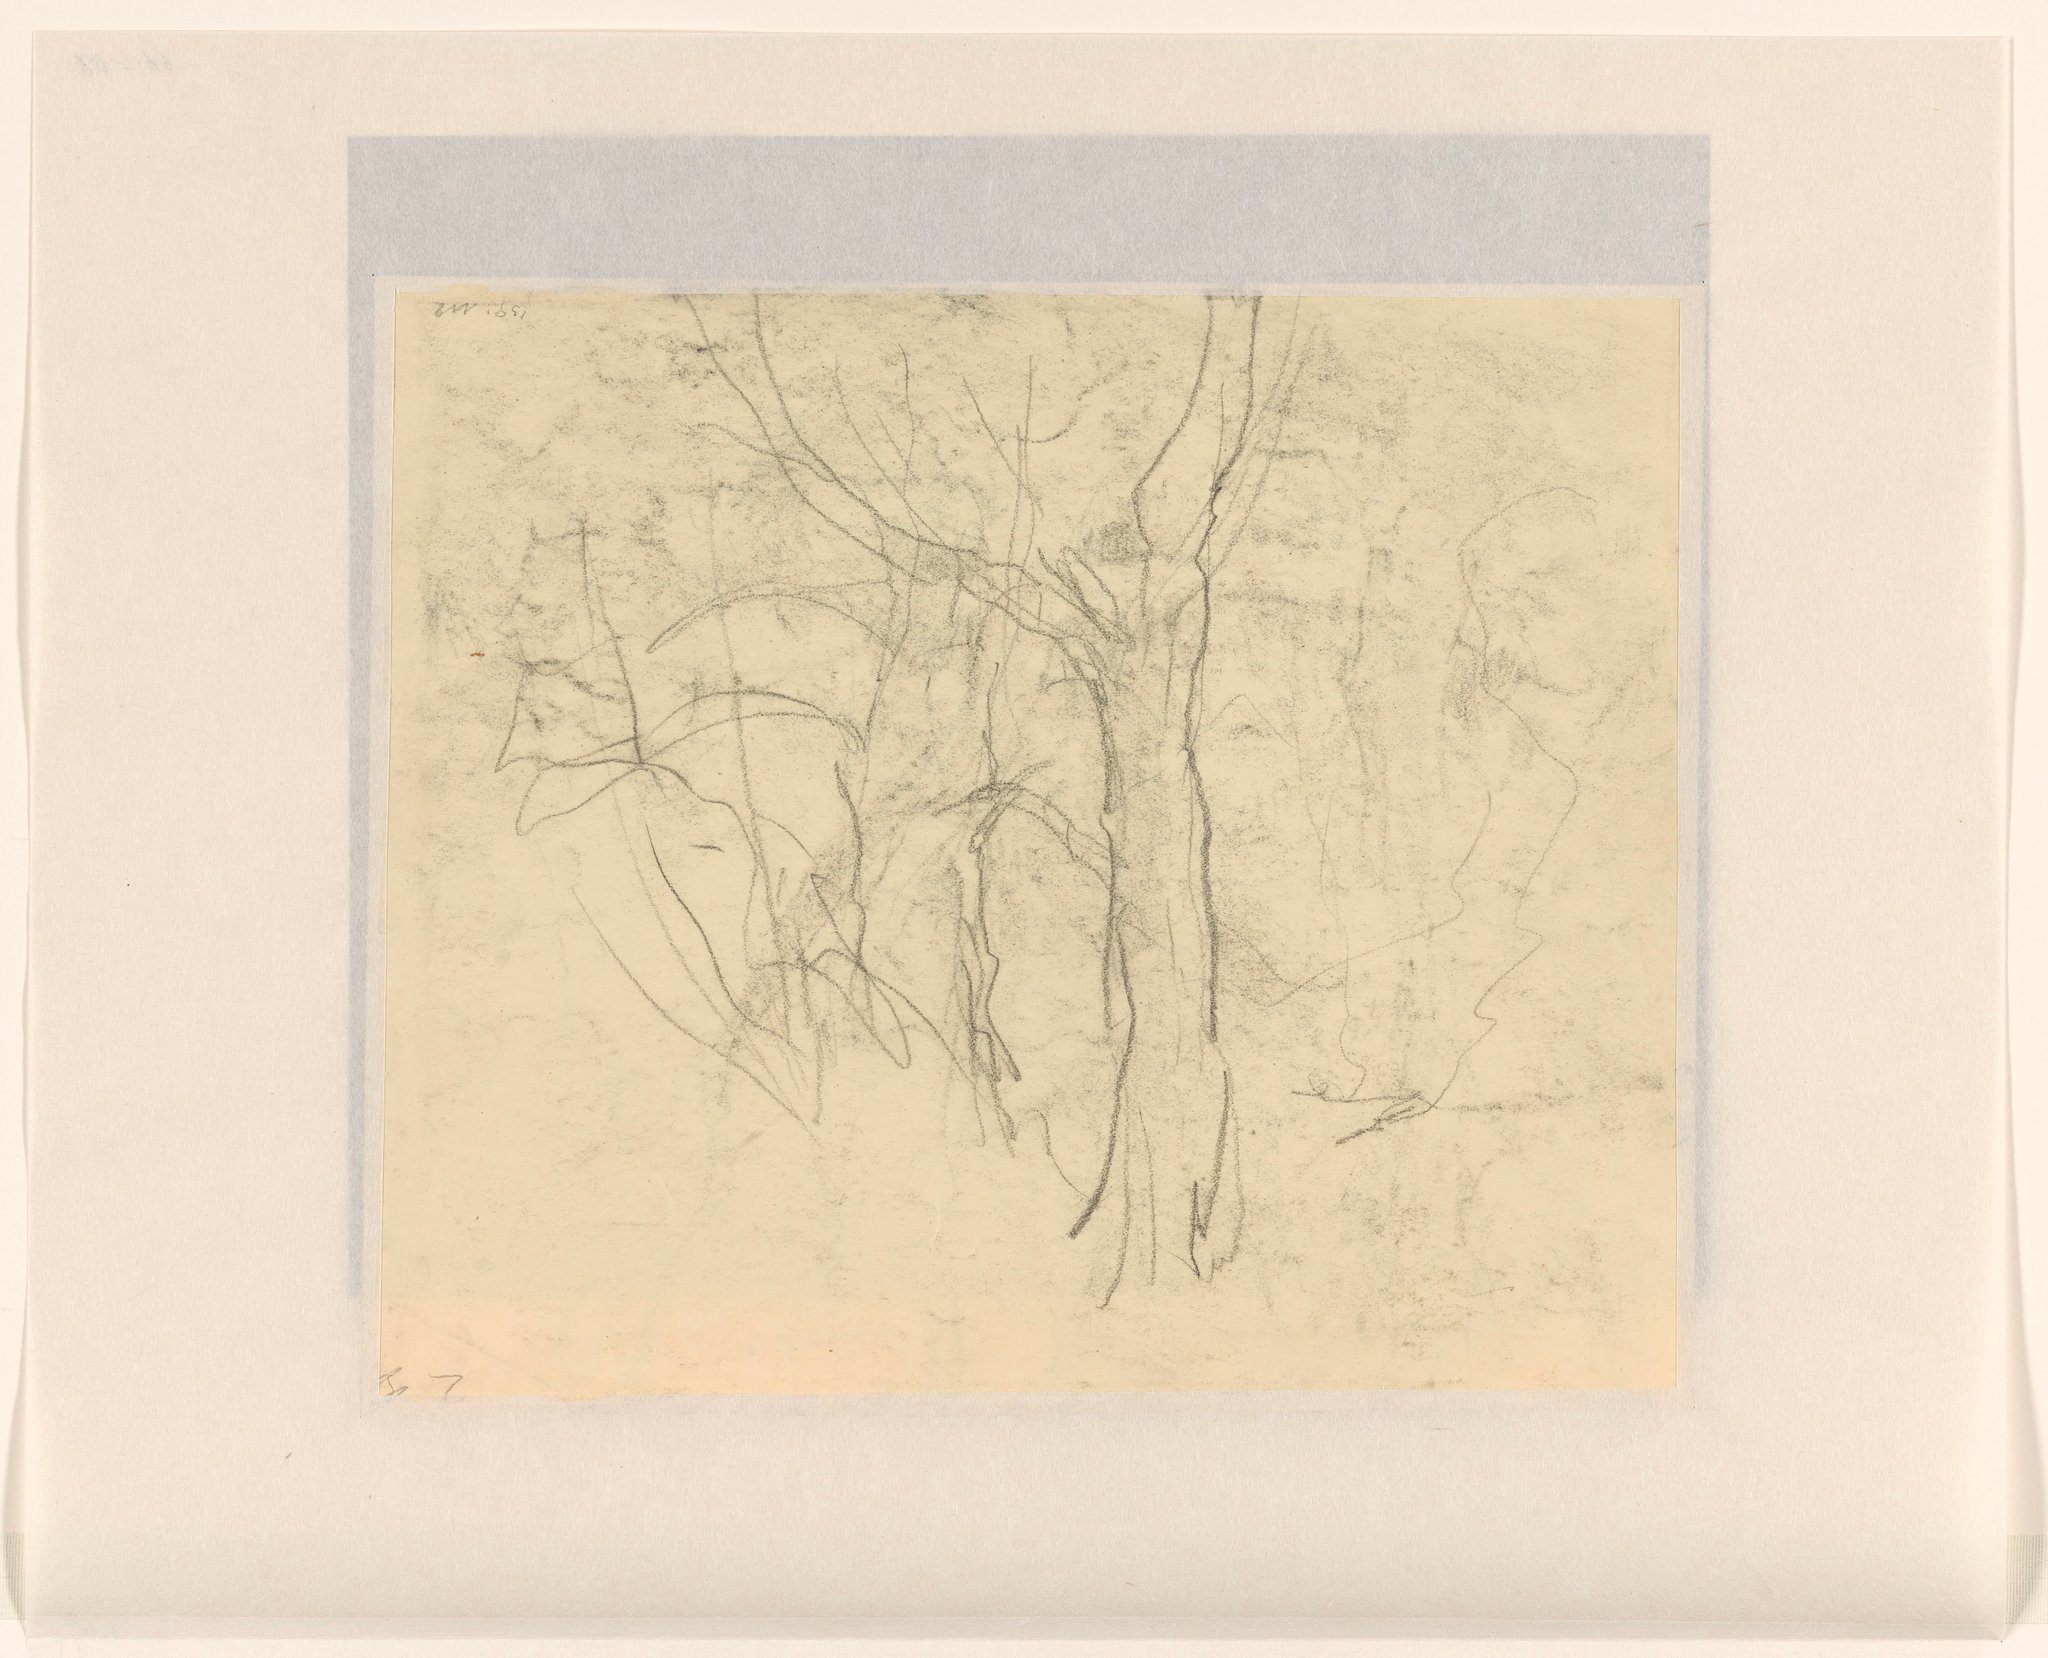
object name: drawing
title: Schets van bomen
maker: egbert rubertus derk schaap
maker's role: draughtsman, painter, print maker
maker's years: 1862-1939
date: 1872-1939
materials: chalk, paper